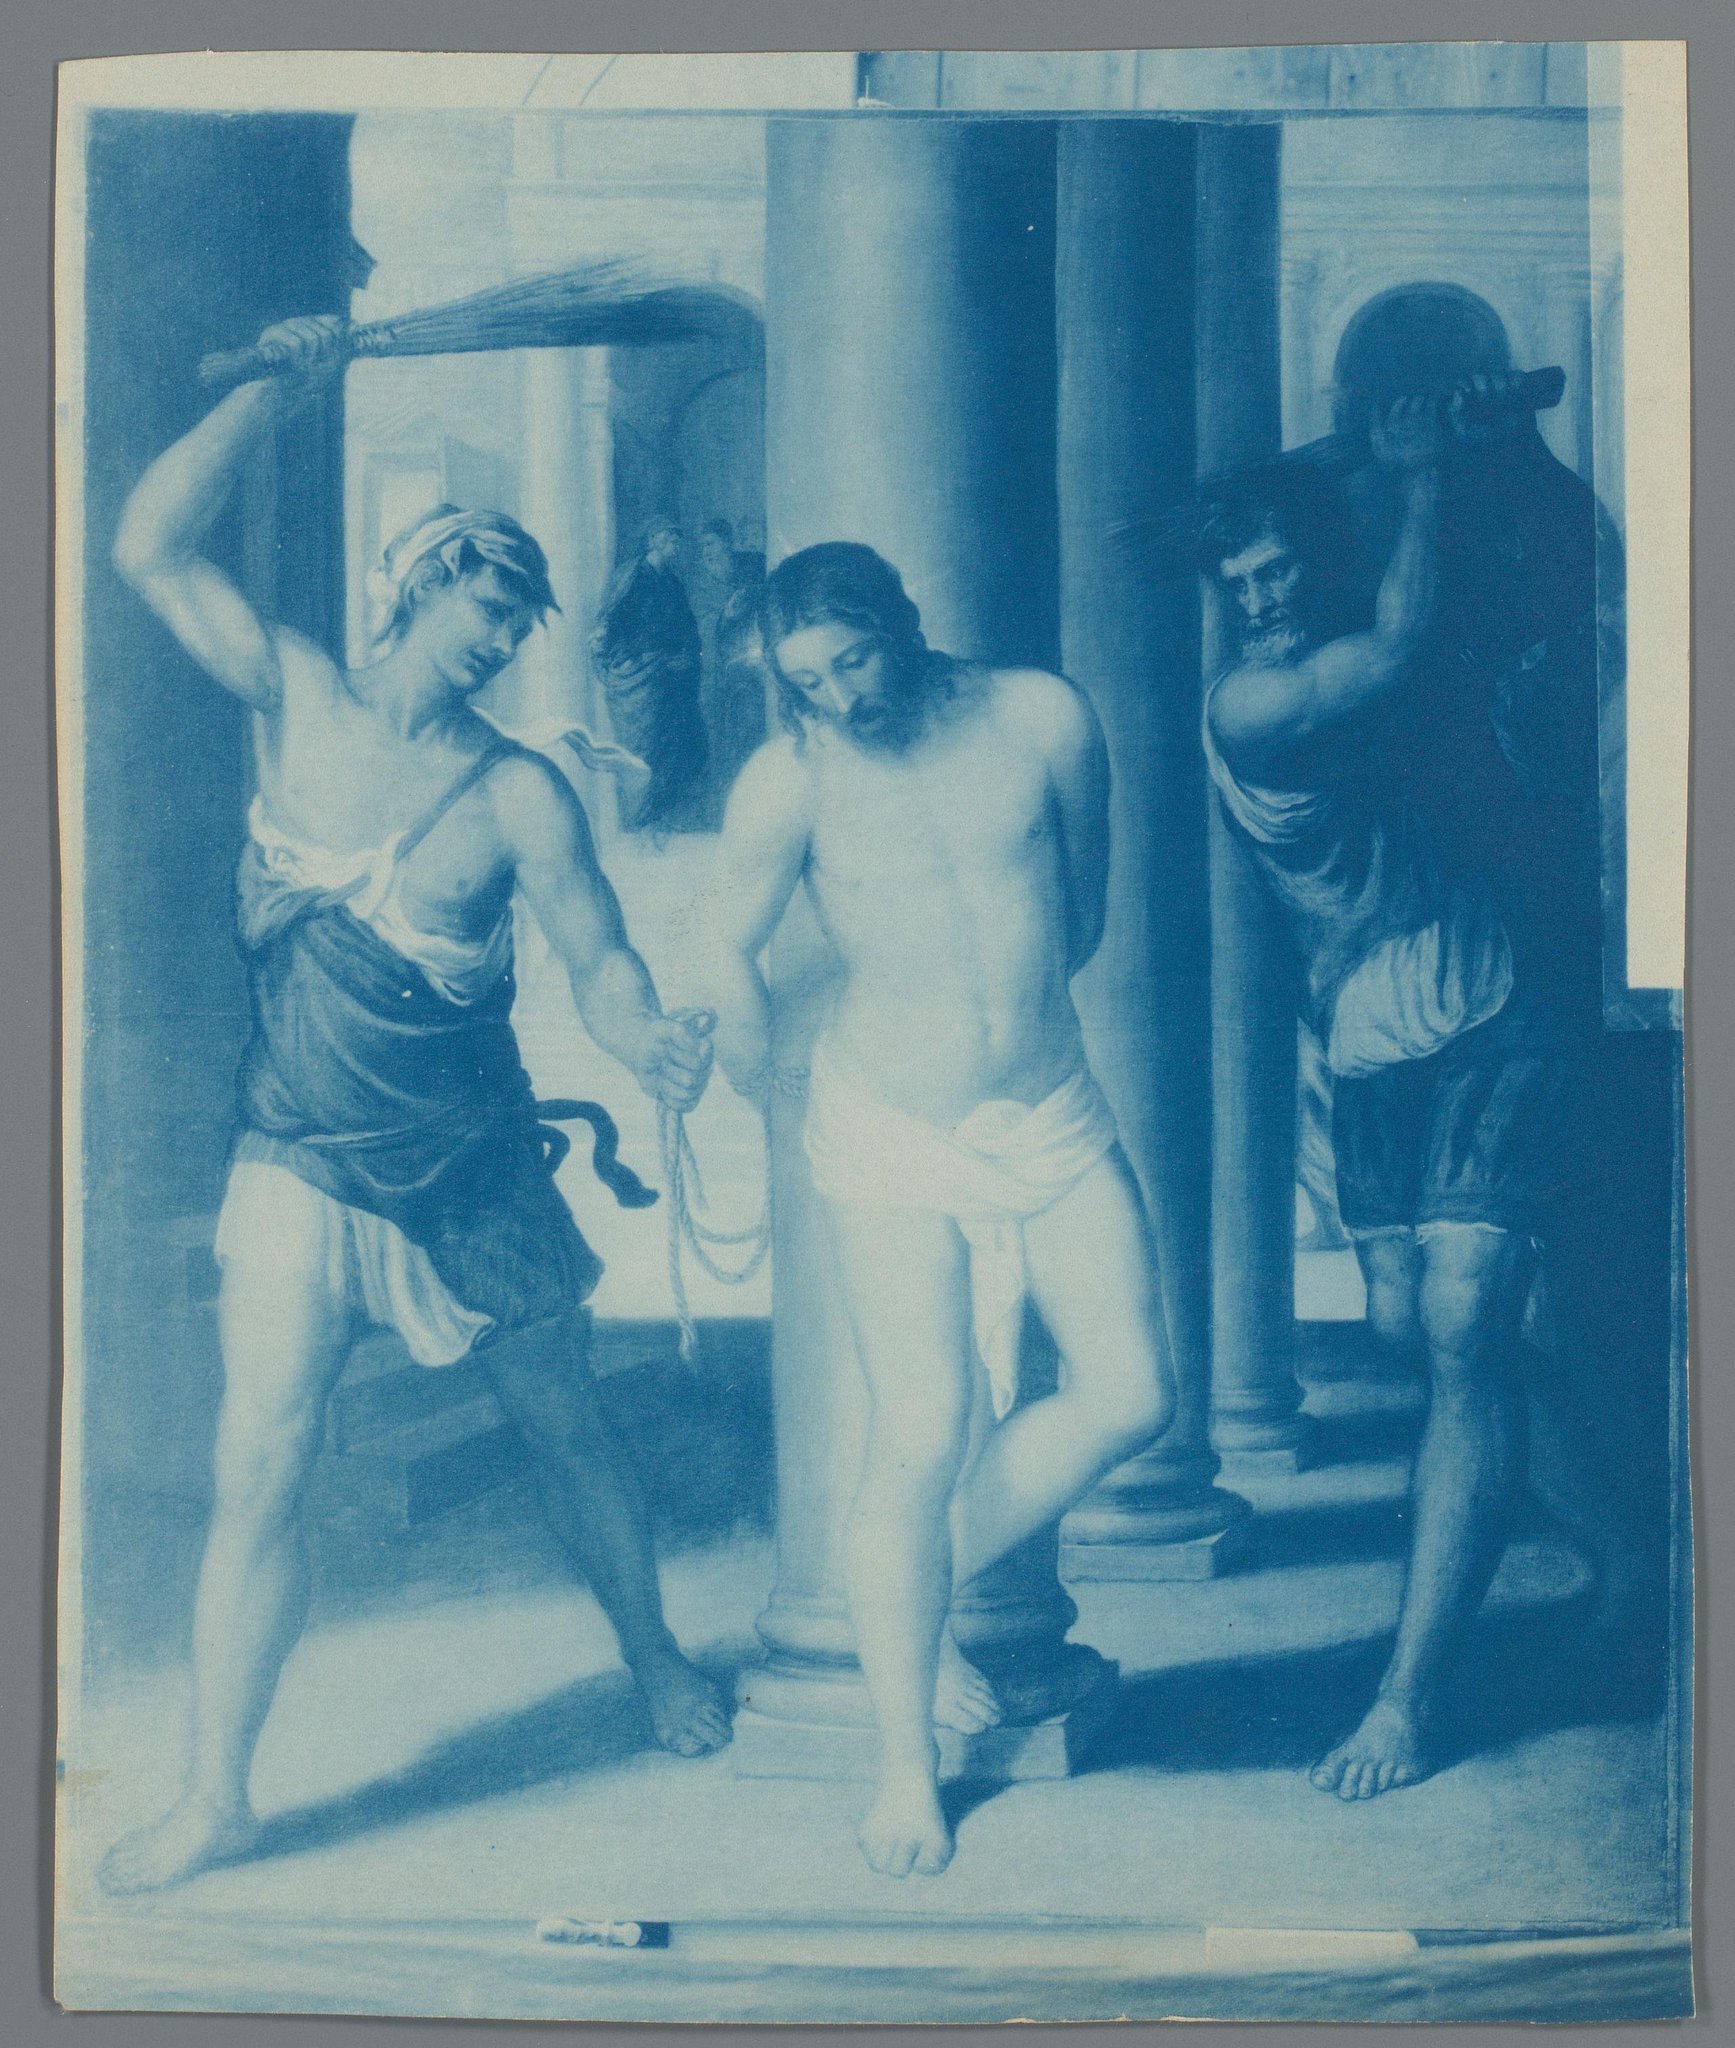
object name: reproduction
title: Fotoreproductie van een schilderij van de geseling van Christus door Andrea Schiavone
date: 1850-1905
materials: paper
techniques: cyanotype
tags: flagellation by soldiers, christ usually tied to a column (matthew 27:26; mark 15:15; john 19:1)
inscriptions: inscription: ‘Andrea Meldolla/ gen./ Schiavone/ 1522-82/ Selenico-Venedig/ 148x131 cm/ Sammlg. Earl of Darnley/ Copie Kunsthist. Museum Wien’, inscription: ‘Andrea Schiavone (gen. Meldella)’